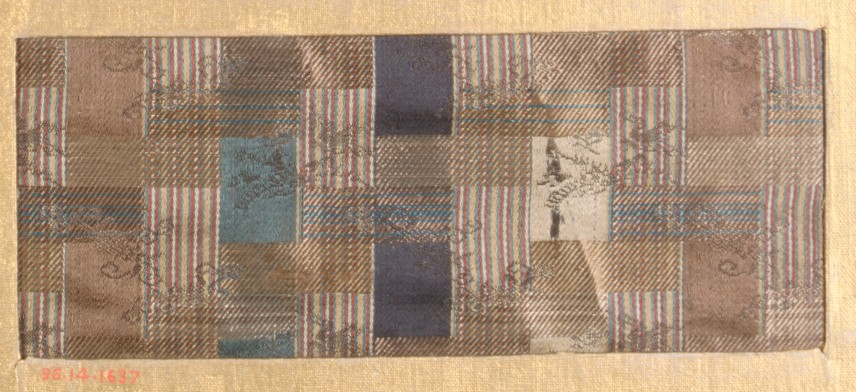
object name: piece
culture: japanese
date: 1701-1900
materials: silk